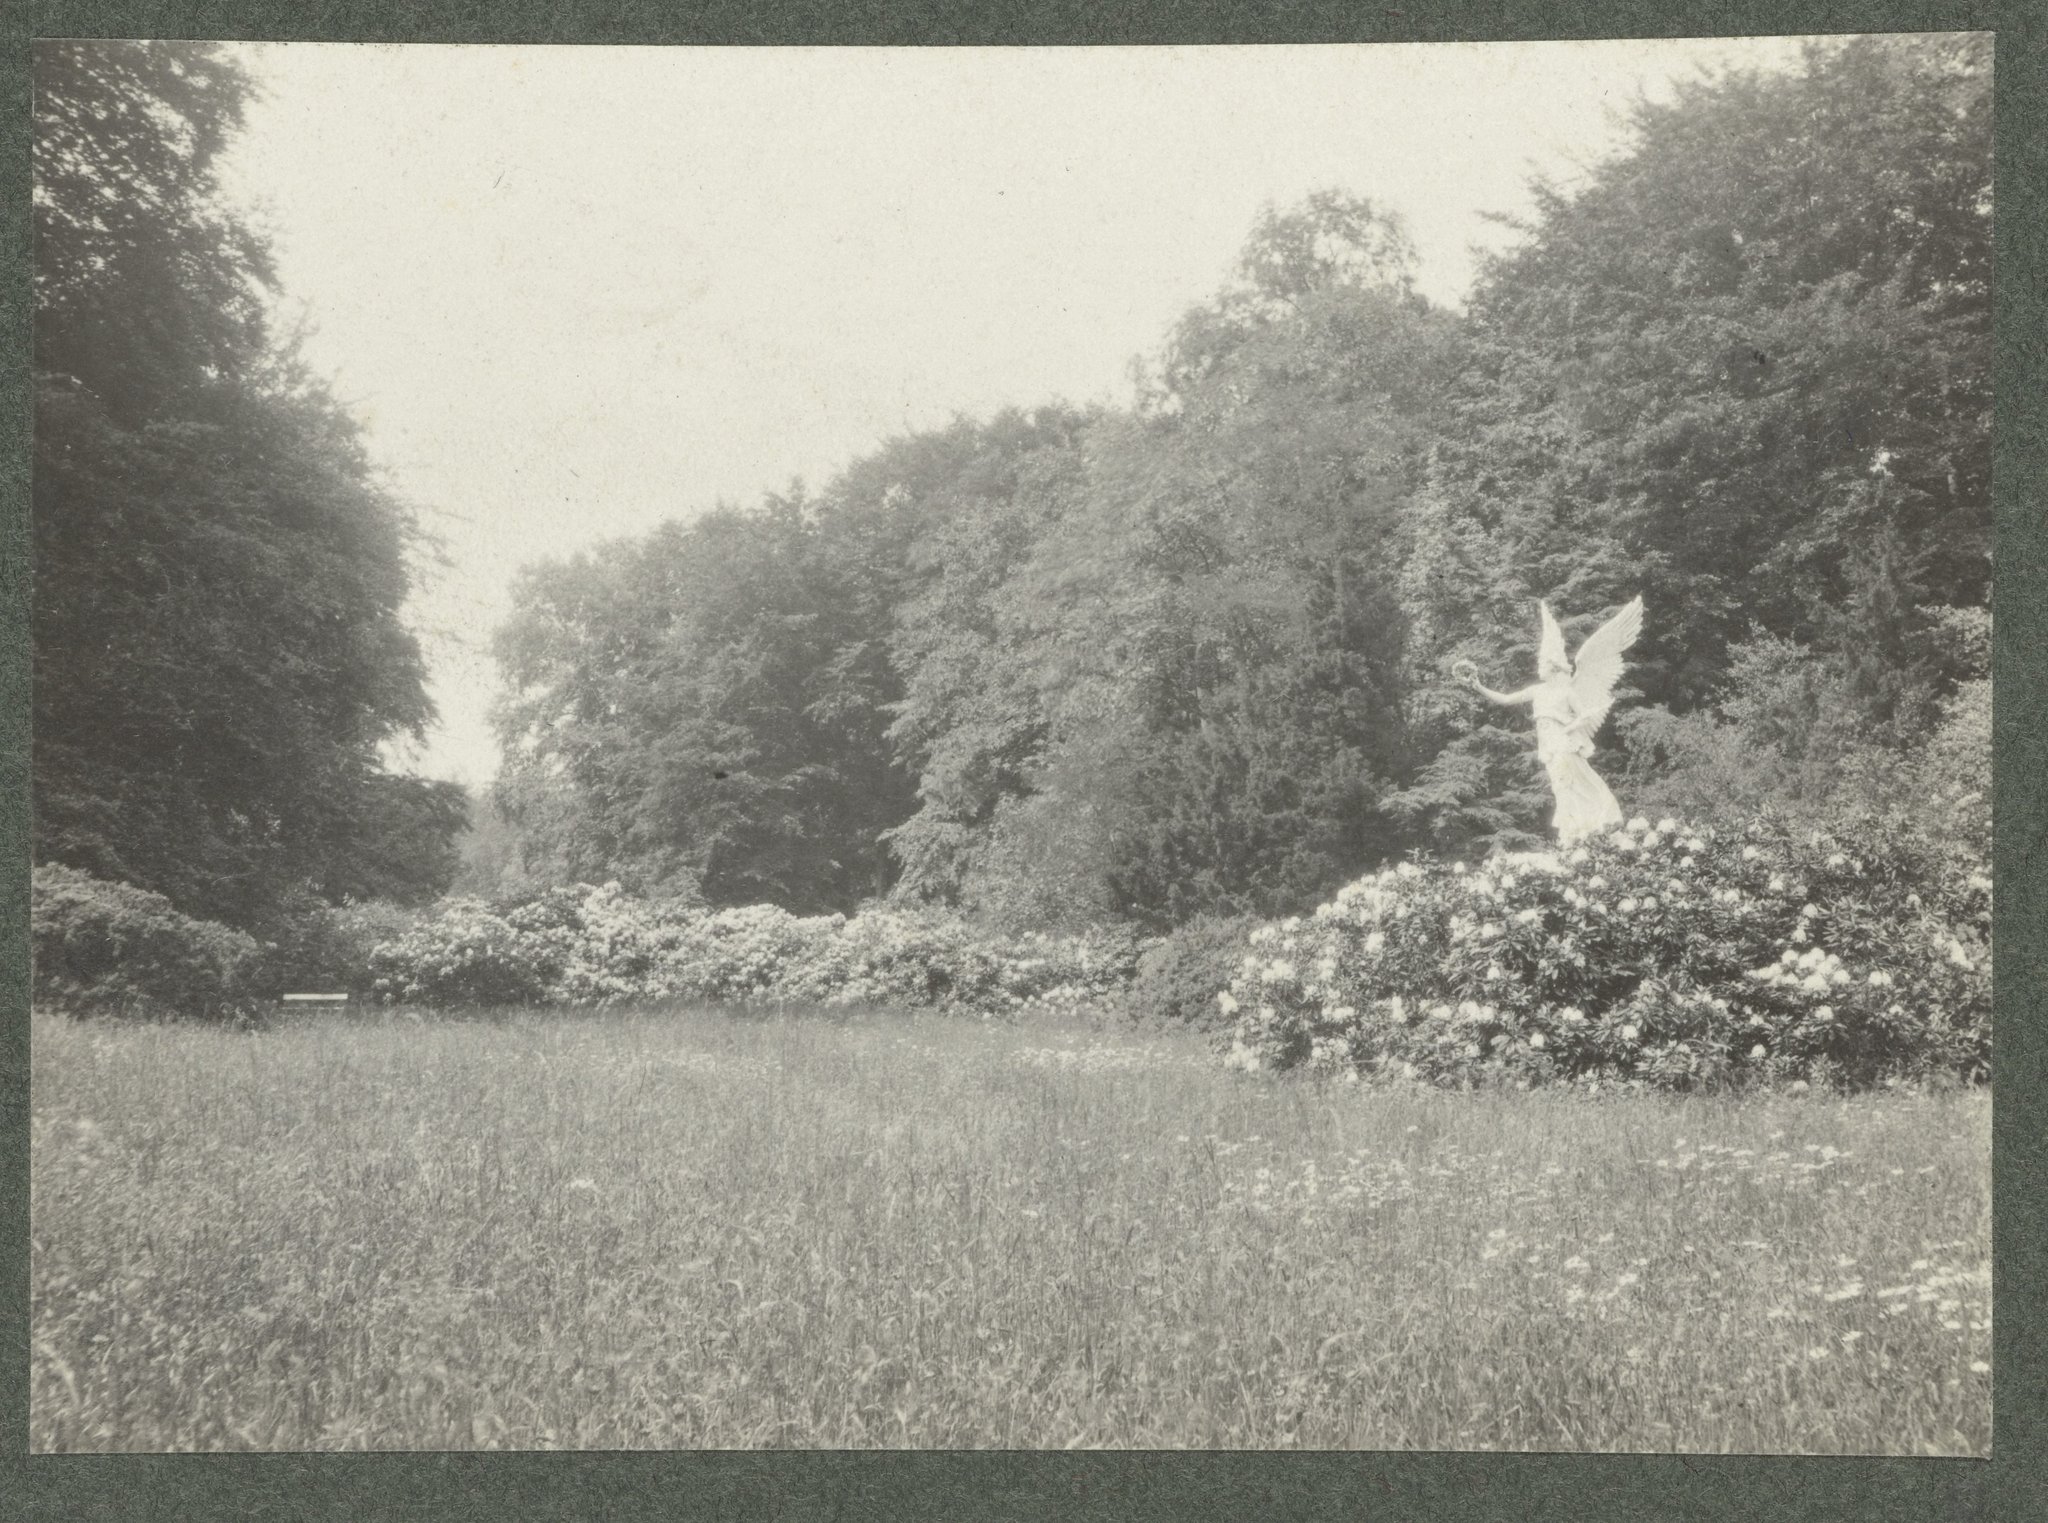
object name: photograph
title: Gezicht op en tuin met beeld van engel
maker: geldolph adriaan kessler (dolph)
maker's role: fotograaf, industrieel, voetballer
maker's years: 1884-1945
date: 1913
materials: paper, photographic support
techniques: photography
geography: netherlands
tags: huize de paauw